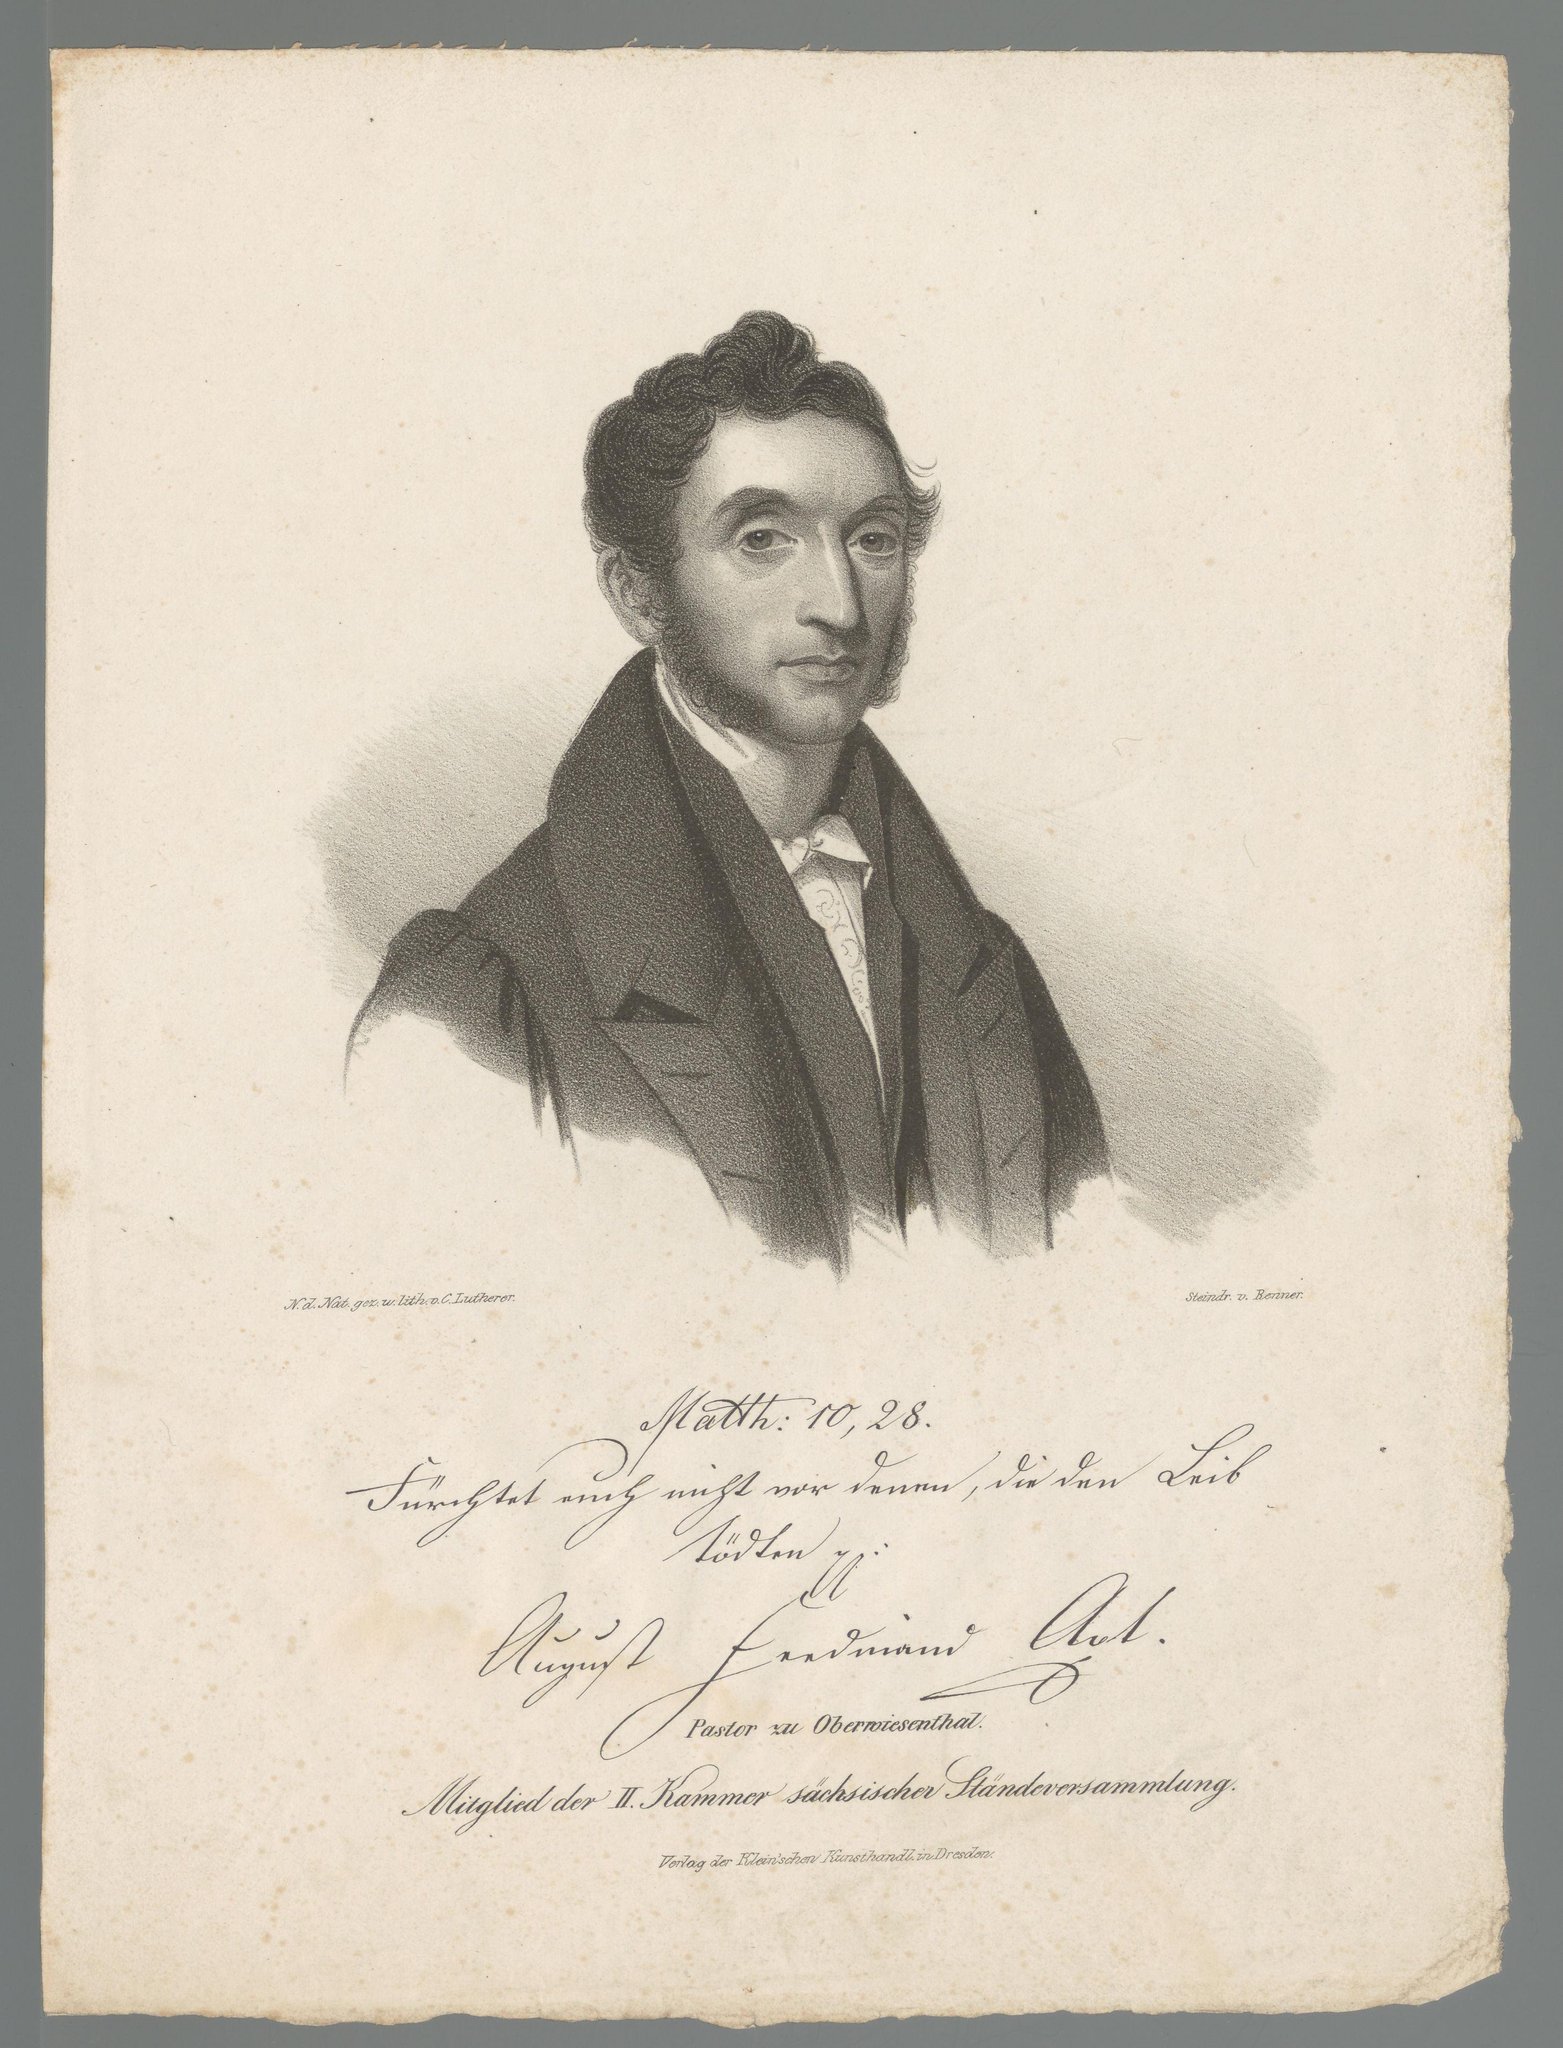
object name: print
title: Portret van August Ferdinand Axt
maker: carl lutherer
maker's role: draughtsman, print maker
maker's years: 1807-1850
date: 1817-1850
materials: paper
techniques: lithograph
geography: dresden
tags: rosswein, politician, historical persons, politician, e.g. party leader, functionaries and dignitaries ~ protestant churches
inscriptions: collector's mark: Lugt 2228